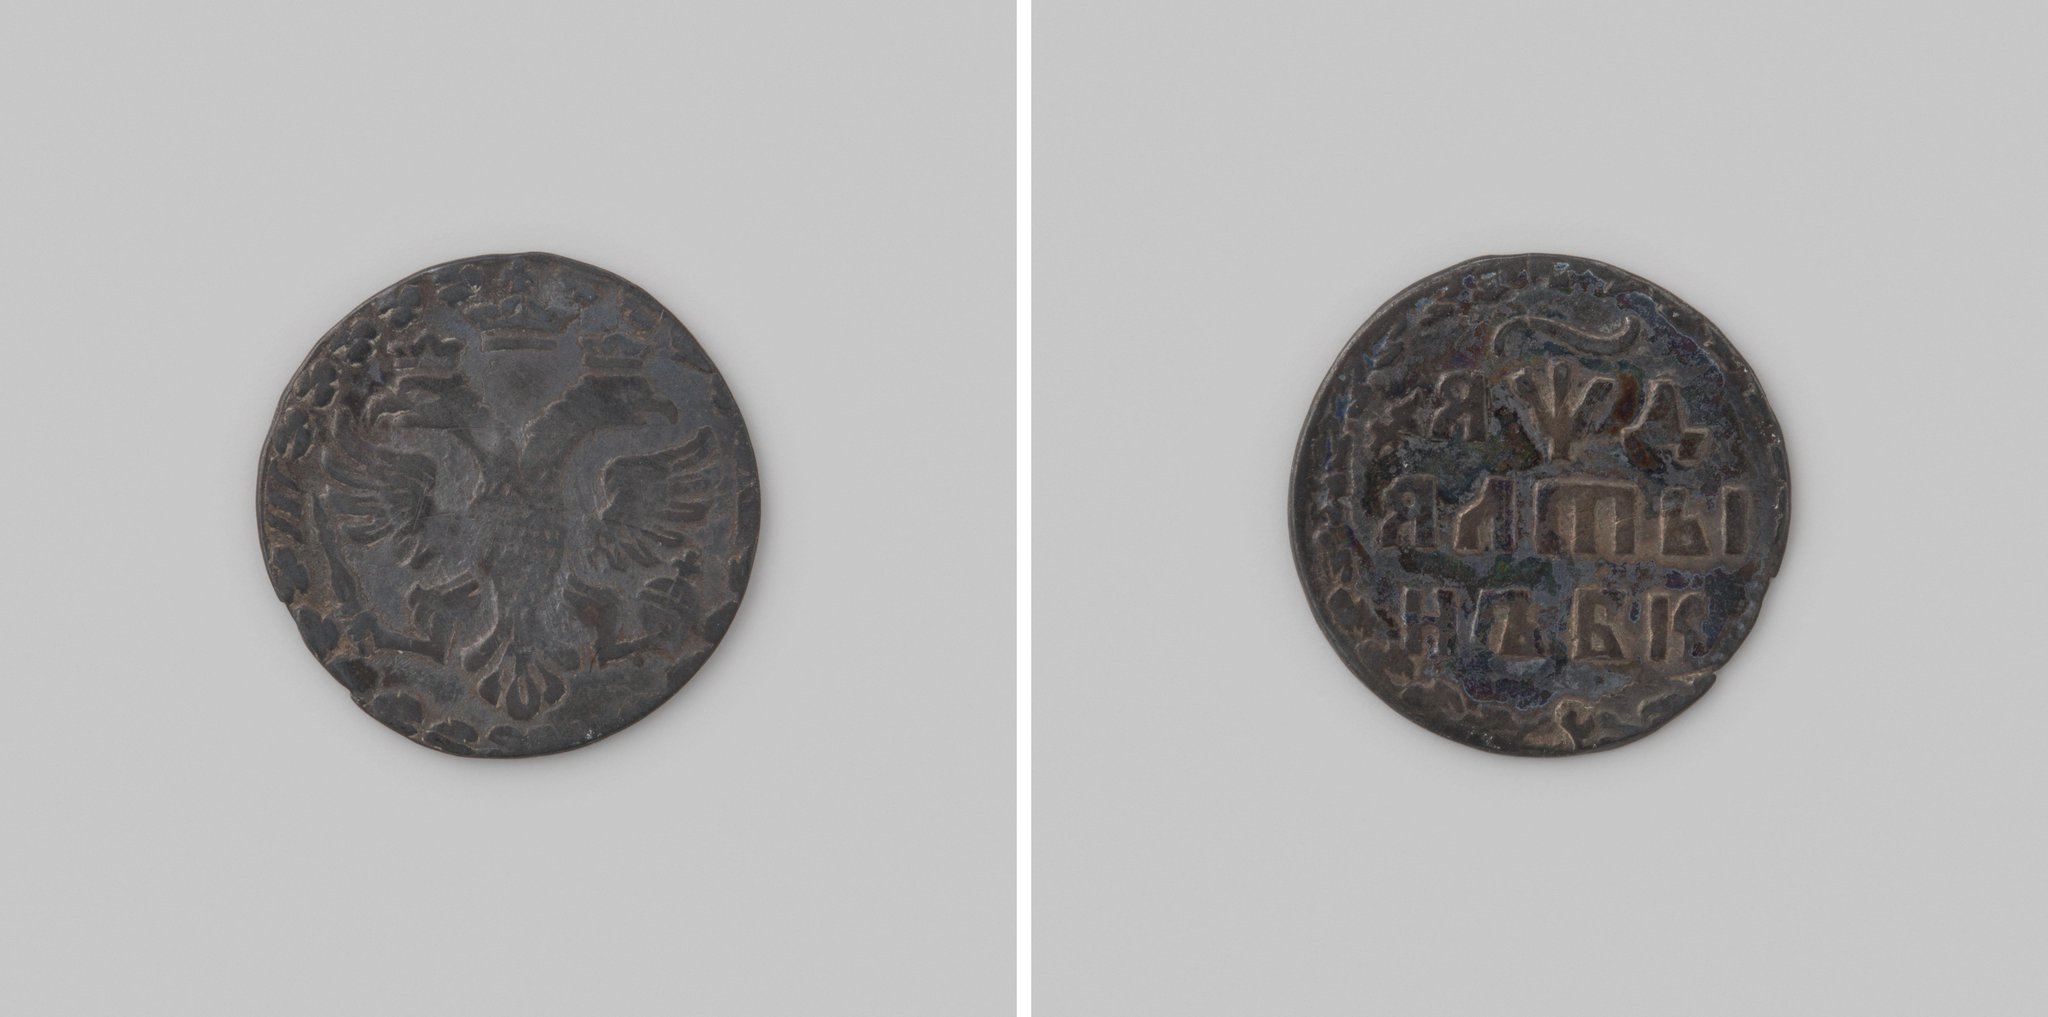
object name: coin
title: Rusland, tsaar Peter I, altinnik of 3 kopeken,1704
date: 1704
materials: silver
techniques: striking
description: Zilveren munt. Voorzijde: dubbelkoppige gekroonde adelaar met gespreide vleugels en met in zijn poten scepter en bol met daarop kruis. Boven de adelaar een kroon. Keerzijde: binnen bloemenkrans in twee regels de waarde-aanduiding: altinnik, waaronder jaartal, in Cyrillische letters. Gladde rand.